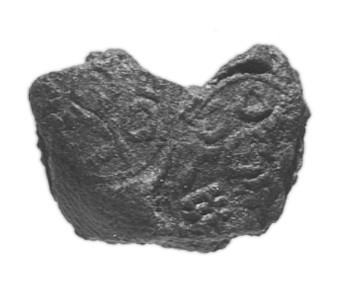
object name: sealing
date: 2030-1640 BCE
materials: clay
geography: egypt